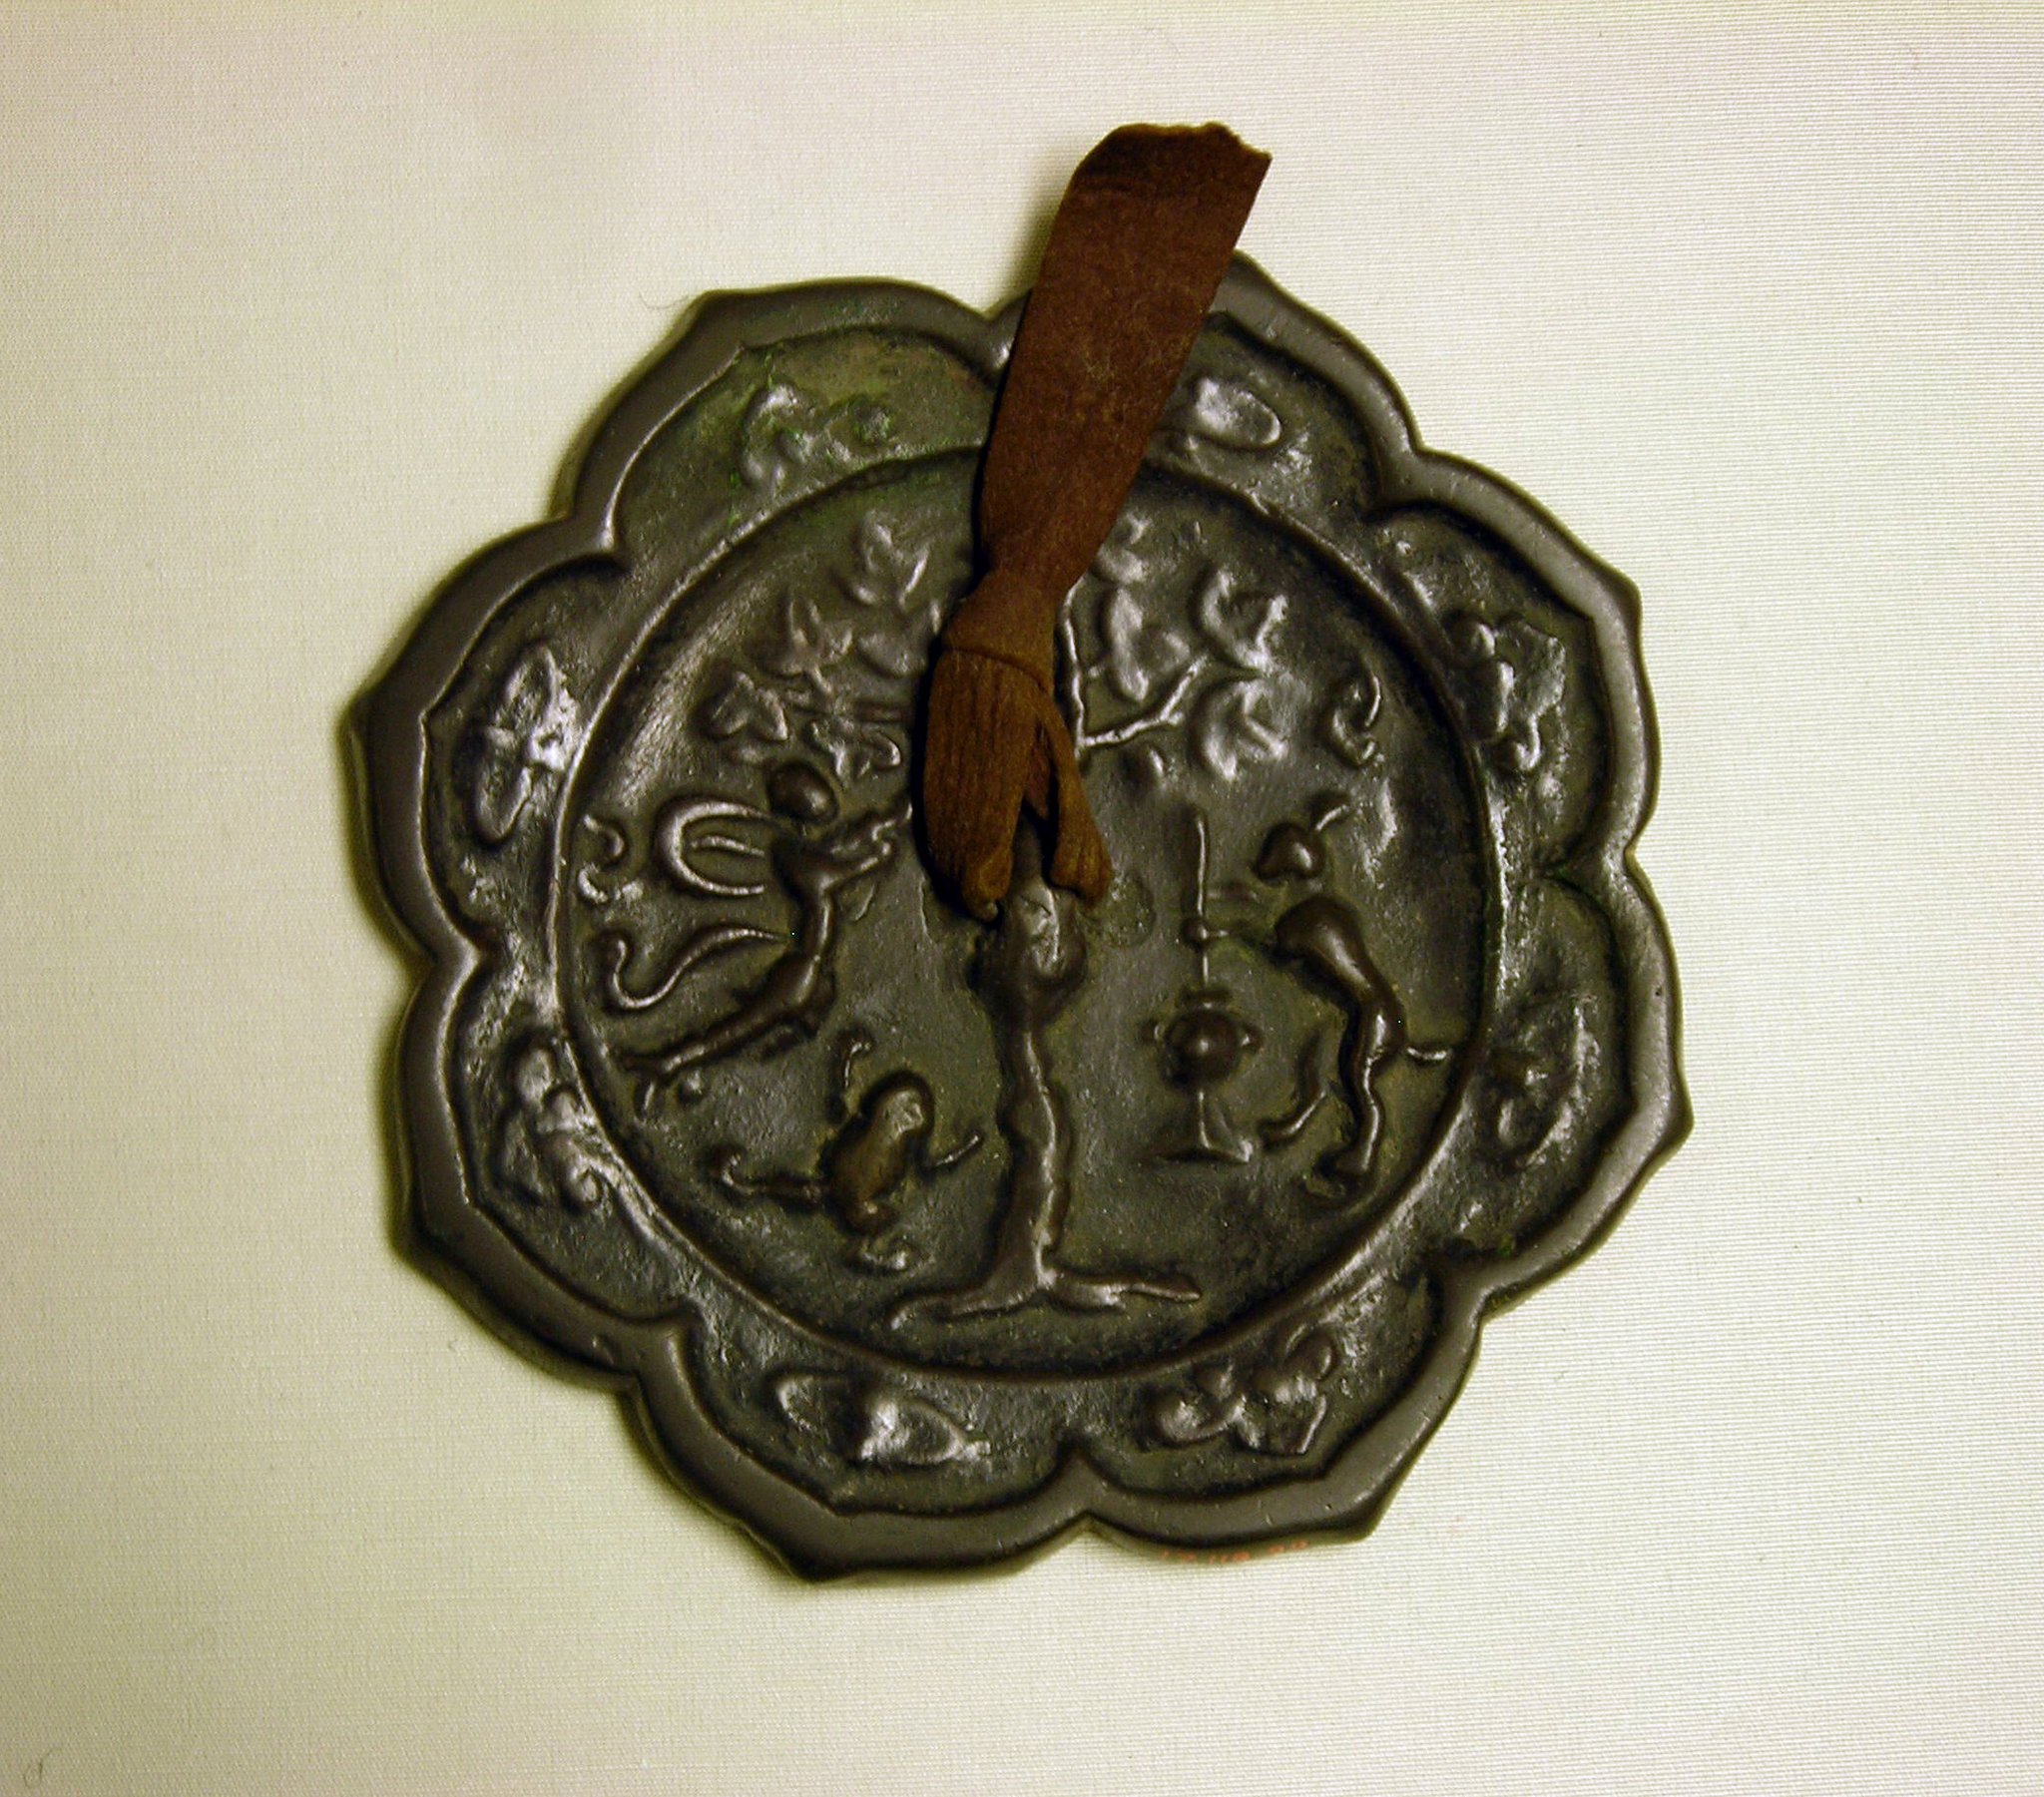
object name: mirror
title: Mirror in the style of the Tang dynasty (618–907)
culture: chinese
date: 1368-1644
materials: bronze